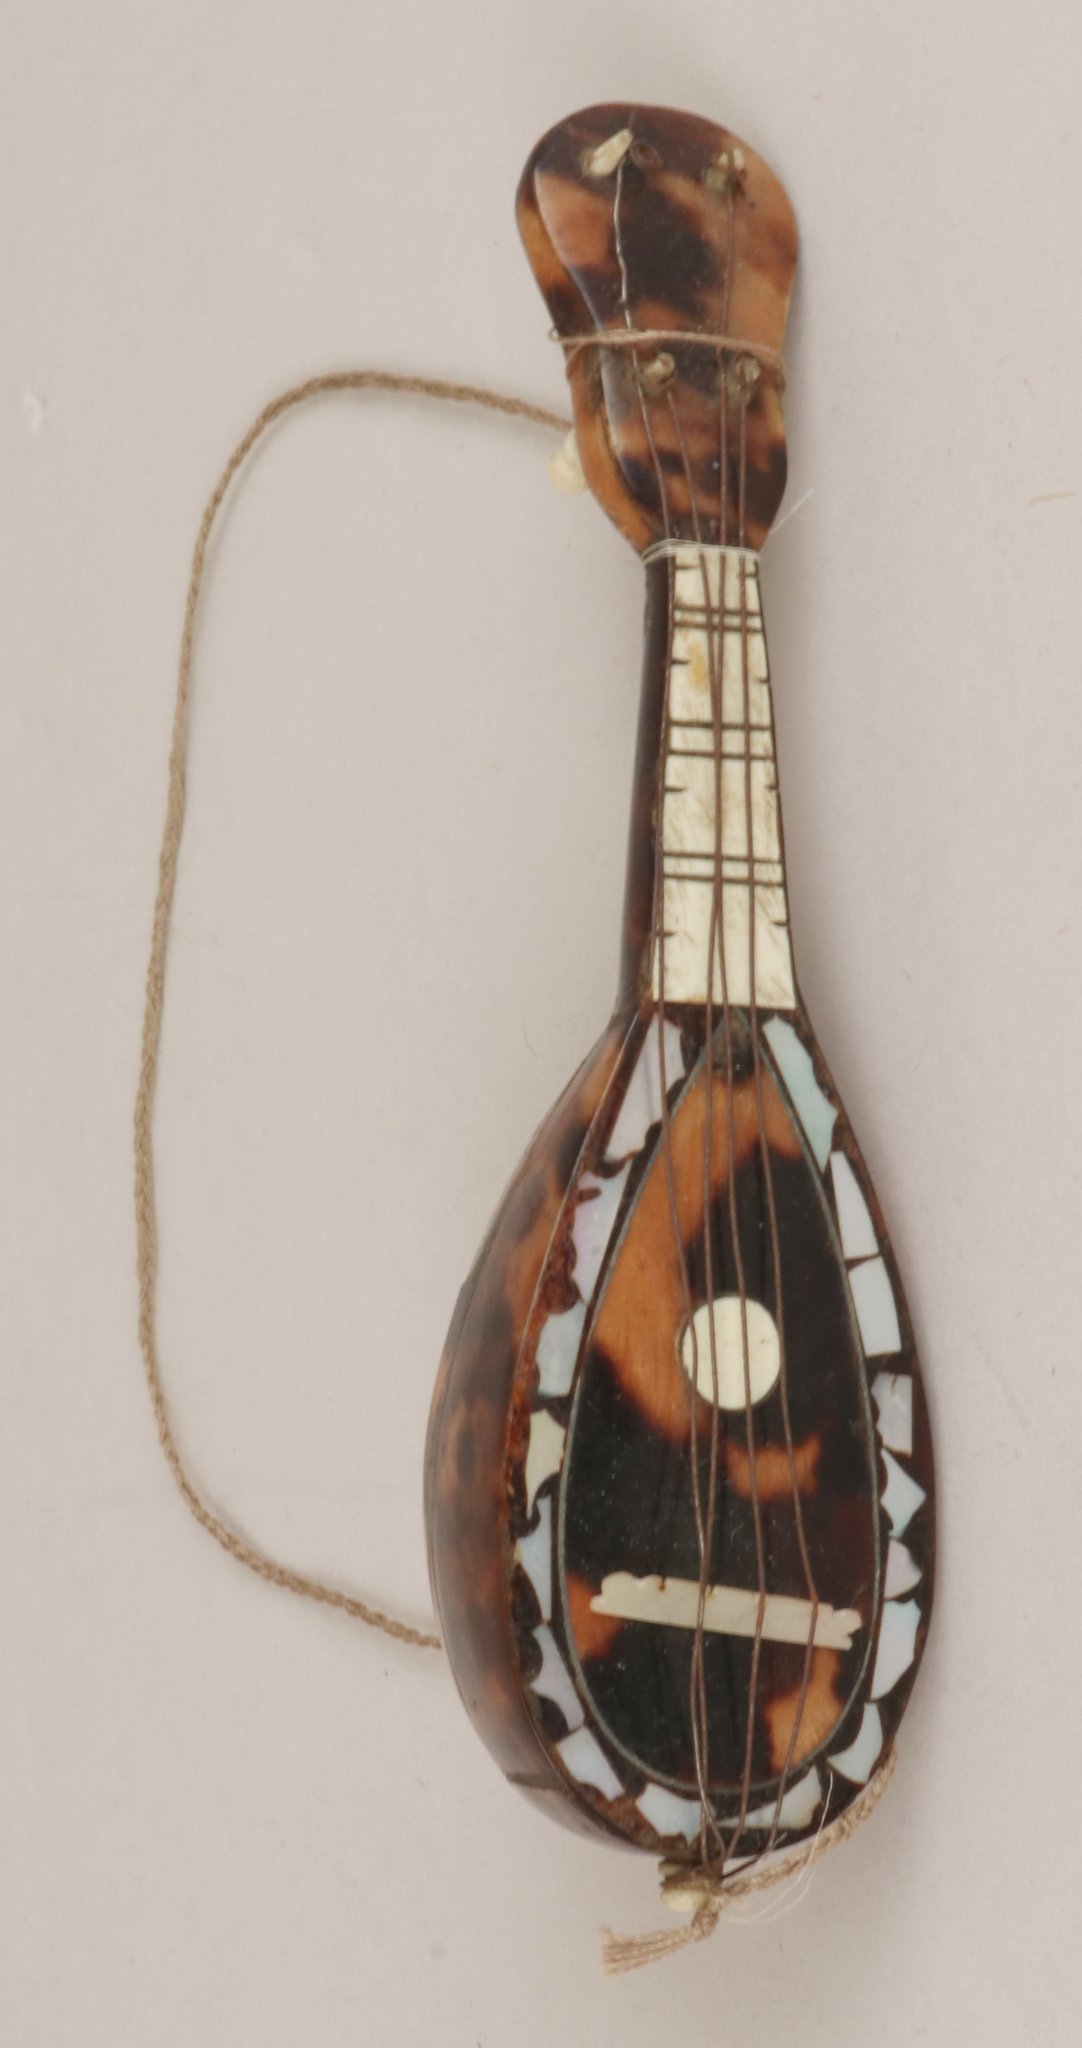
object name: crèche accessory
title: Mandolin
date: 1701-1800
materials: wood